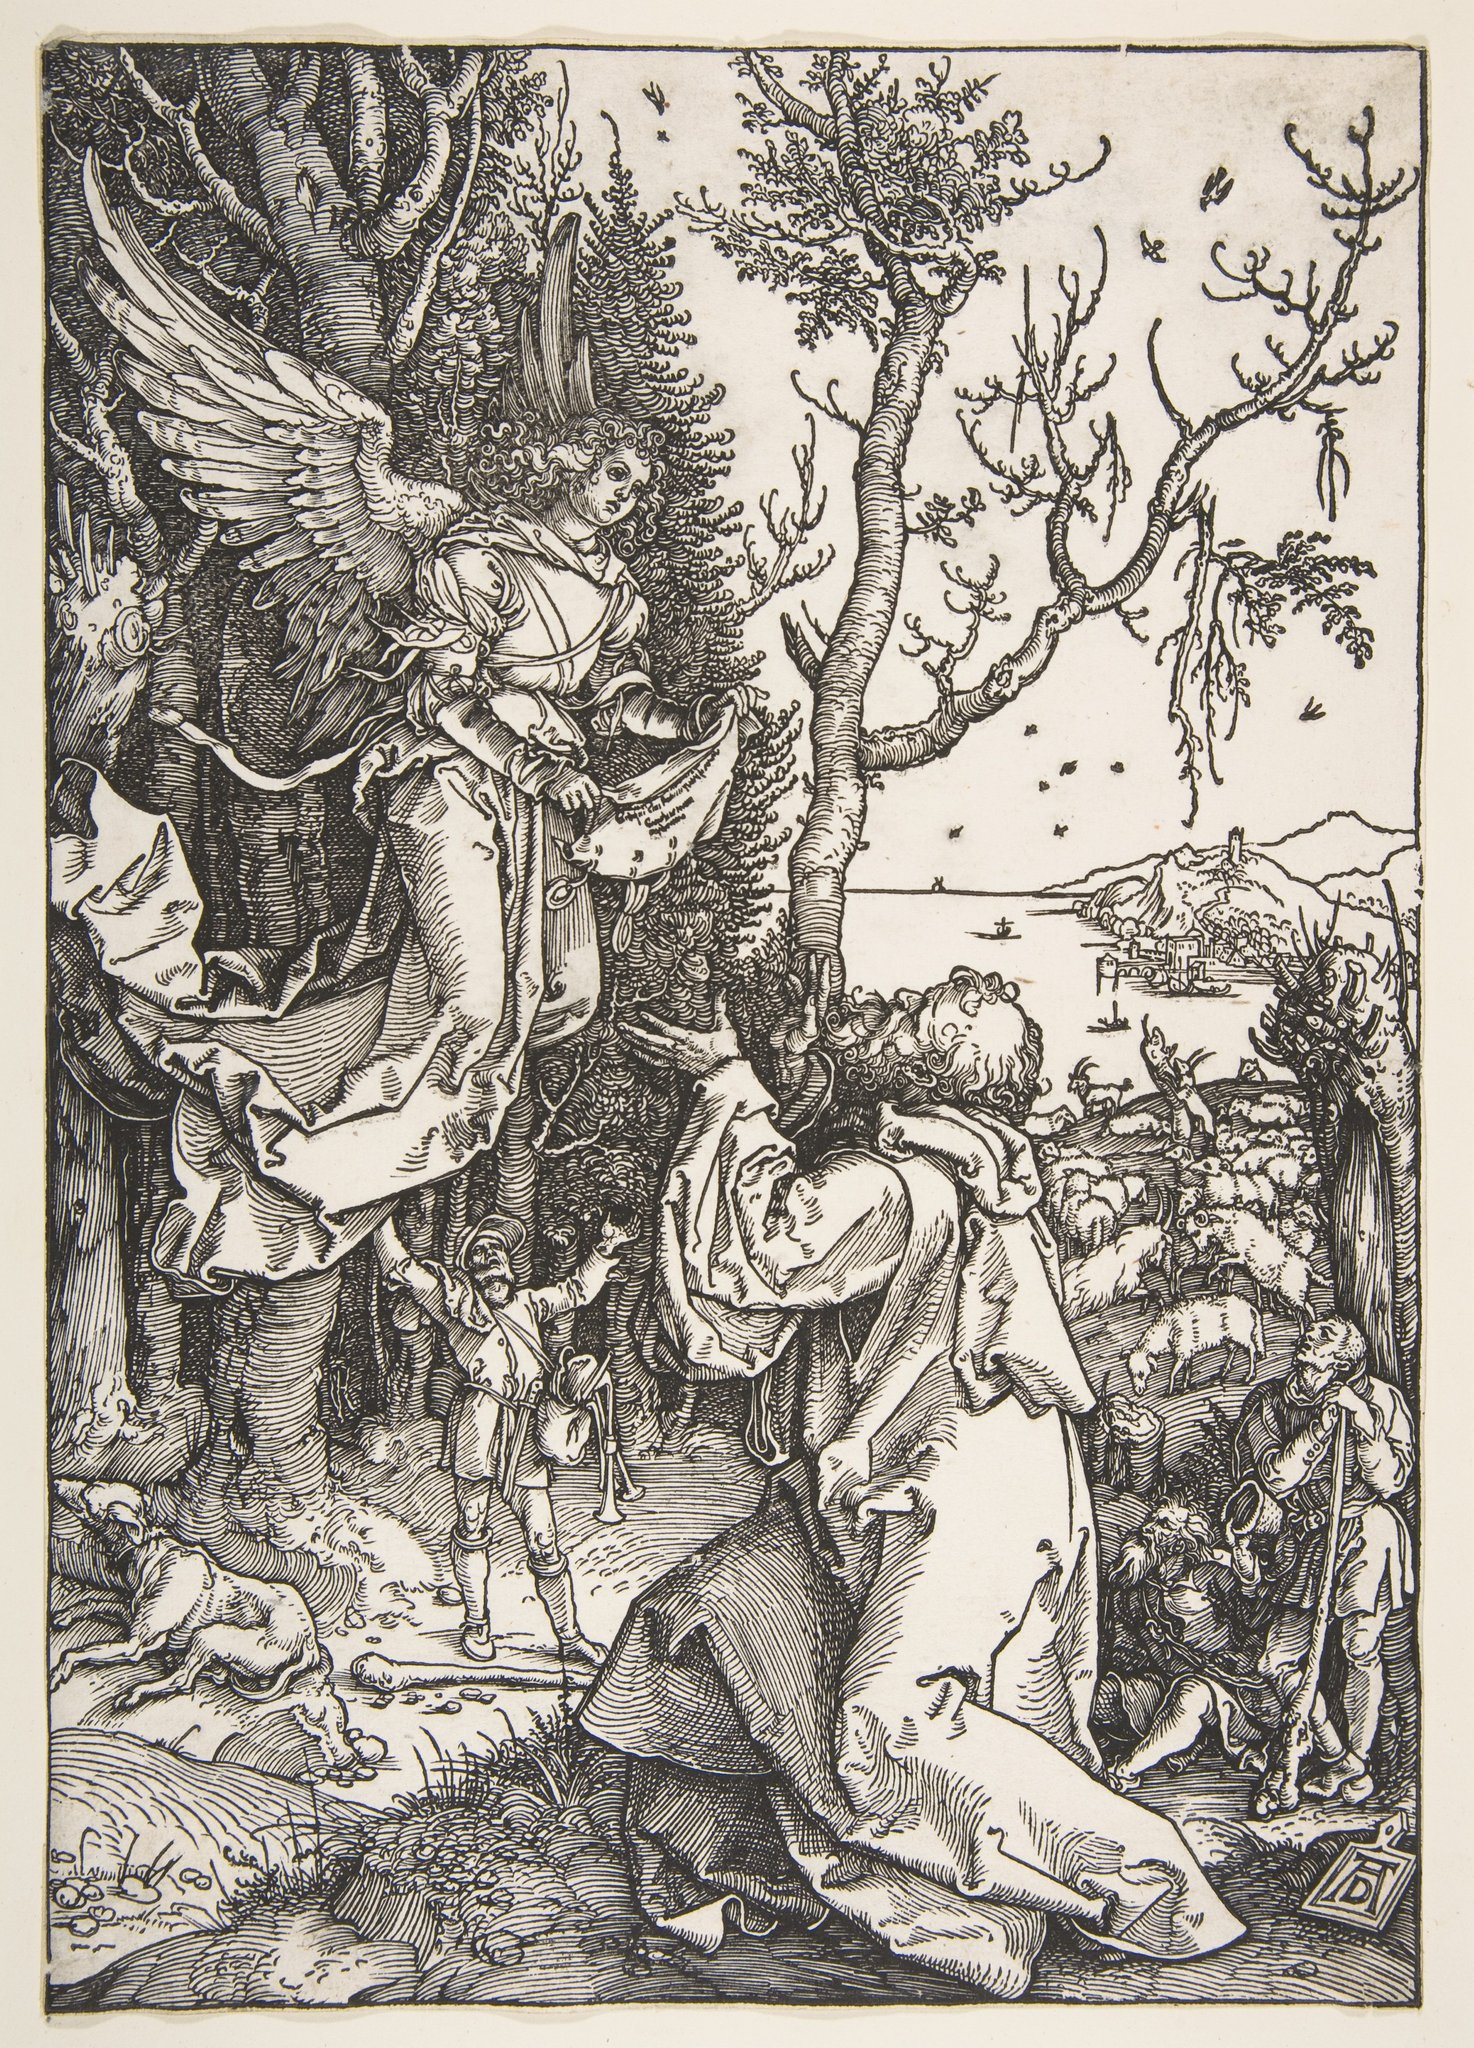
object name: print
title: Joachim and the Angel, from "The Life of the Virgin"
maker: albrecht dürer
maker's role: artist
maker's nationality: german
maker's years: 1471-1528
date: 1504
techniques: woodcut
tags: men,trees,angels